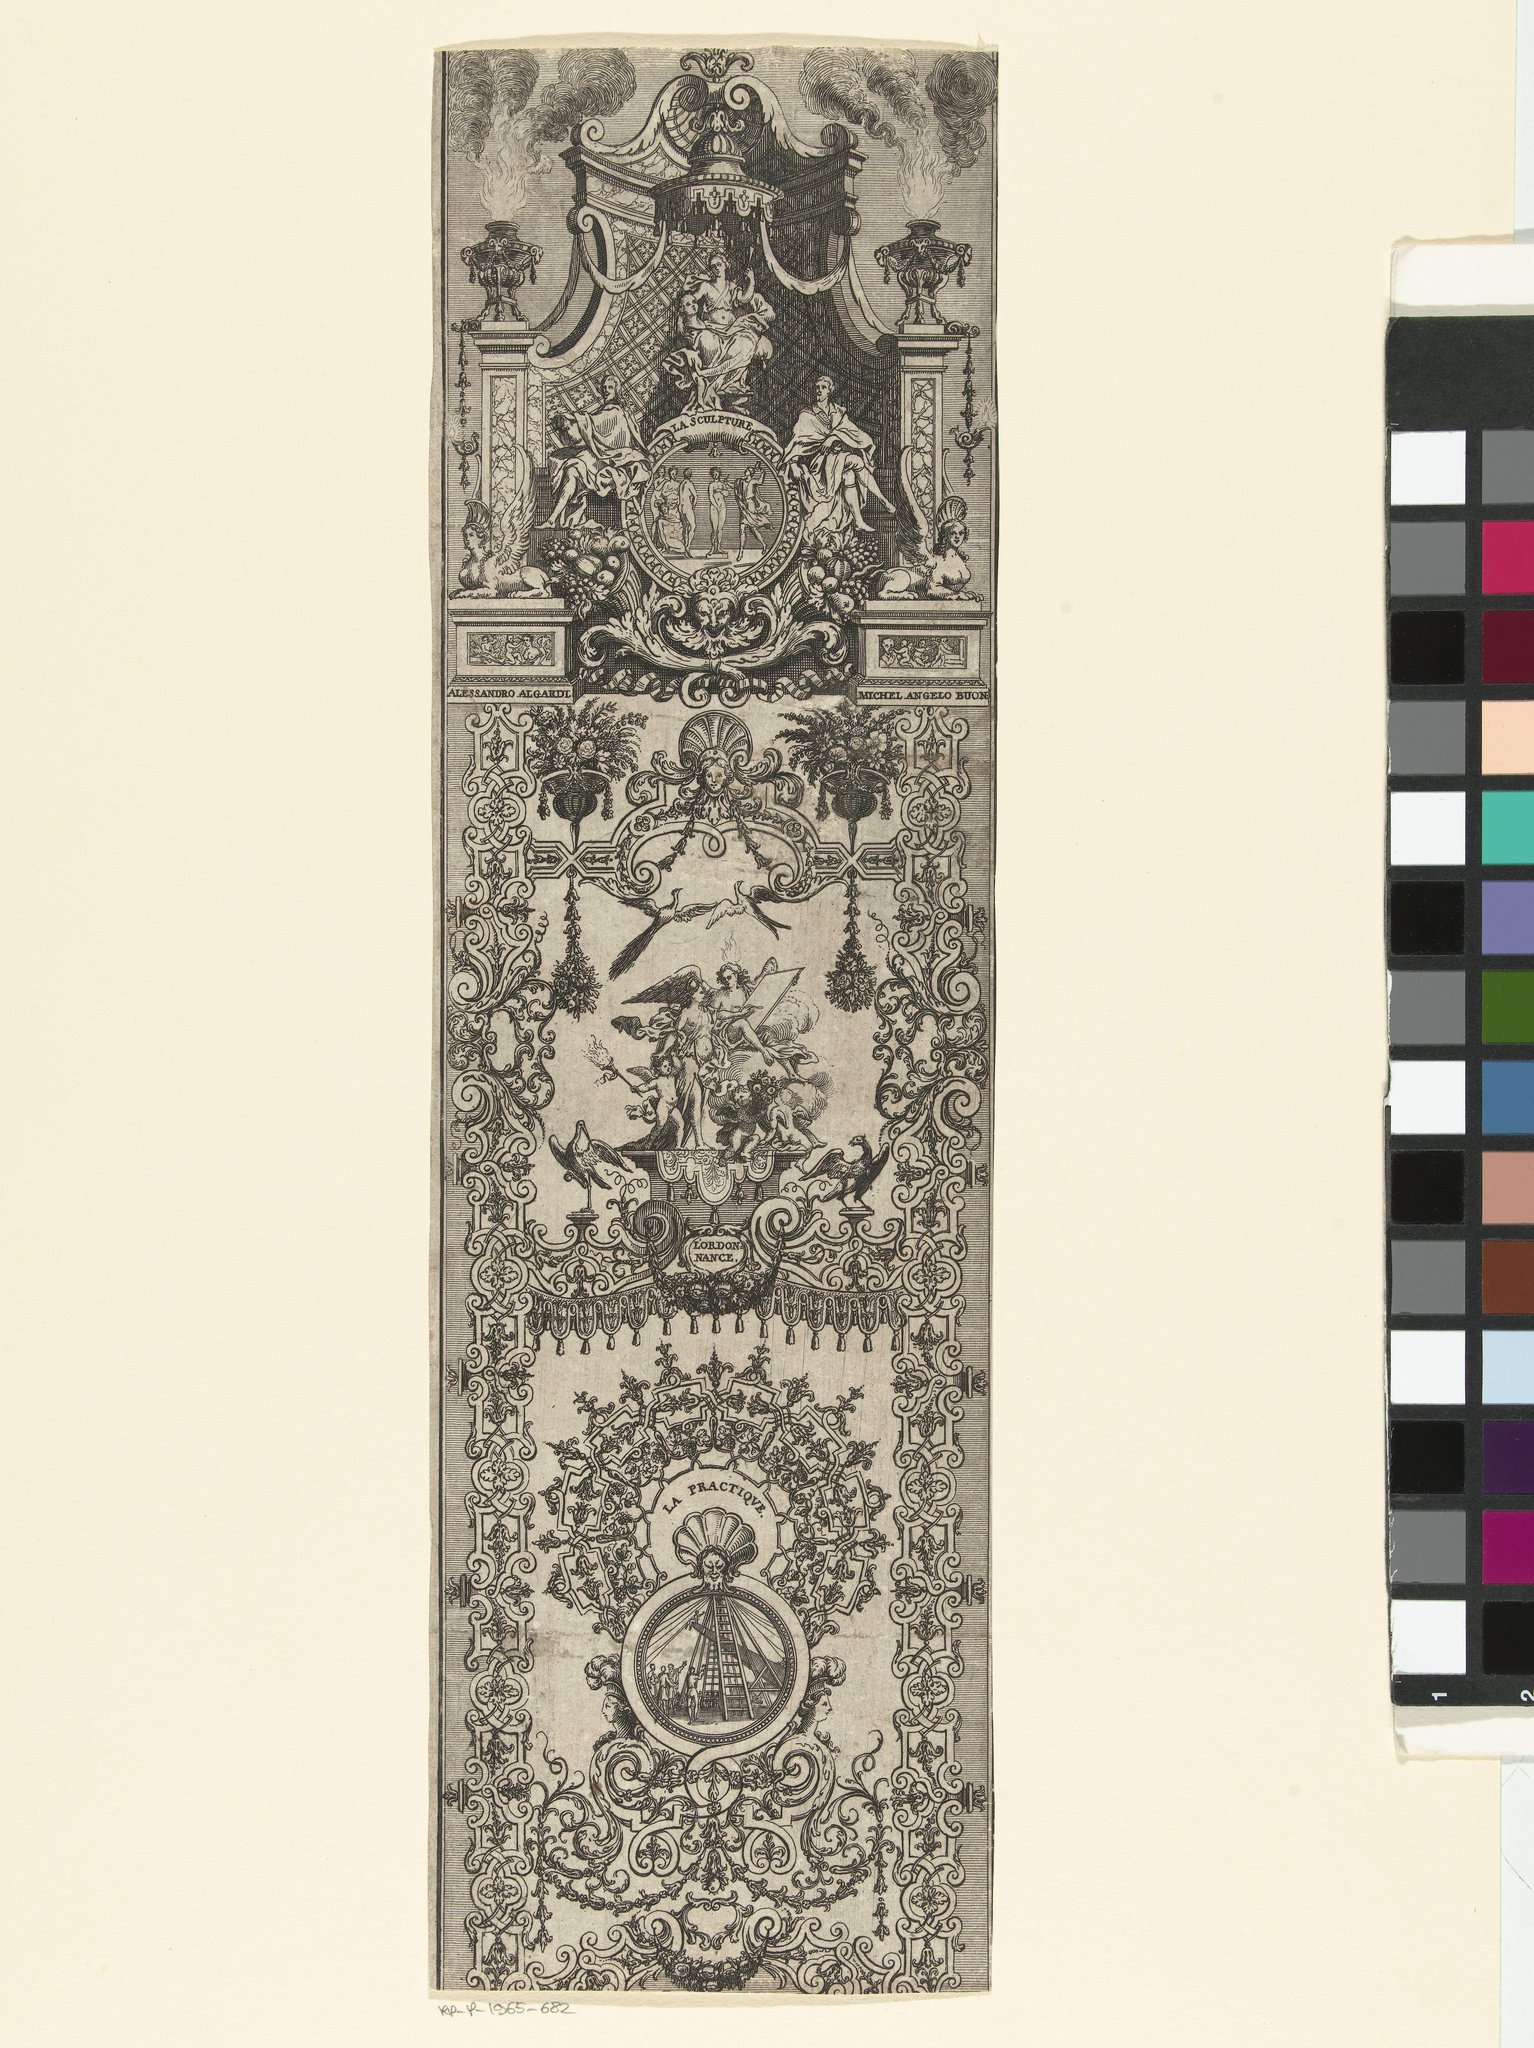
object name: print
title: Plafond met de kunsten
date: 1647-1714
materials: paper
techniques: etching